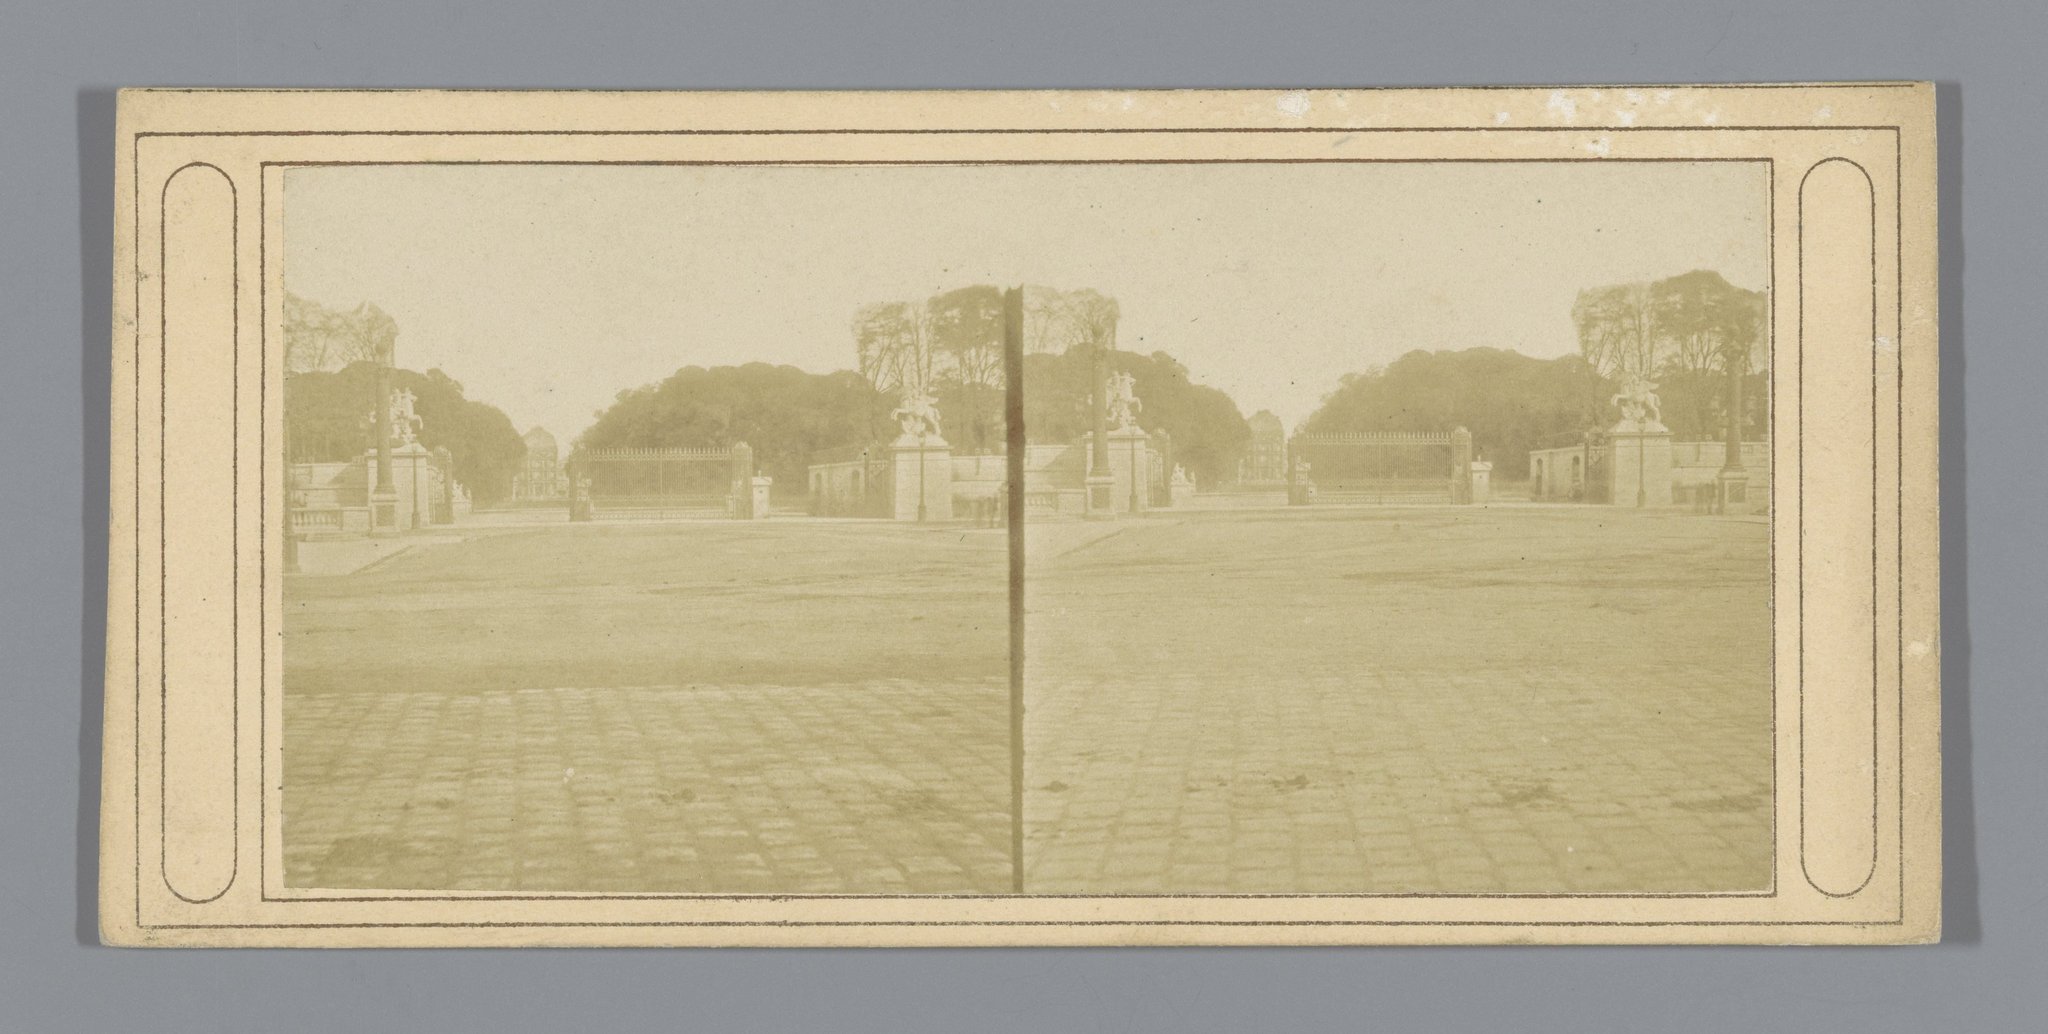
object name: stereograph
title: Tuilerieën te Parijs, met zicht op het Place de la Concorde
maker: Anonymous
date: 1850-1875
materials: cardboard, photographic support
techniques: albumen print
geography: jardin des tuileries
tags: french or architectonic garden; formal garden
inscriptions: number: ‘No 9’, inscription: ‘vue des tuileries’